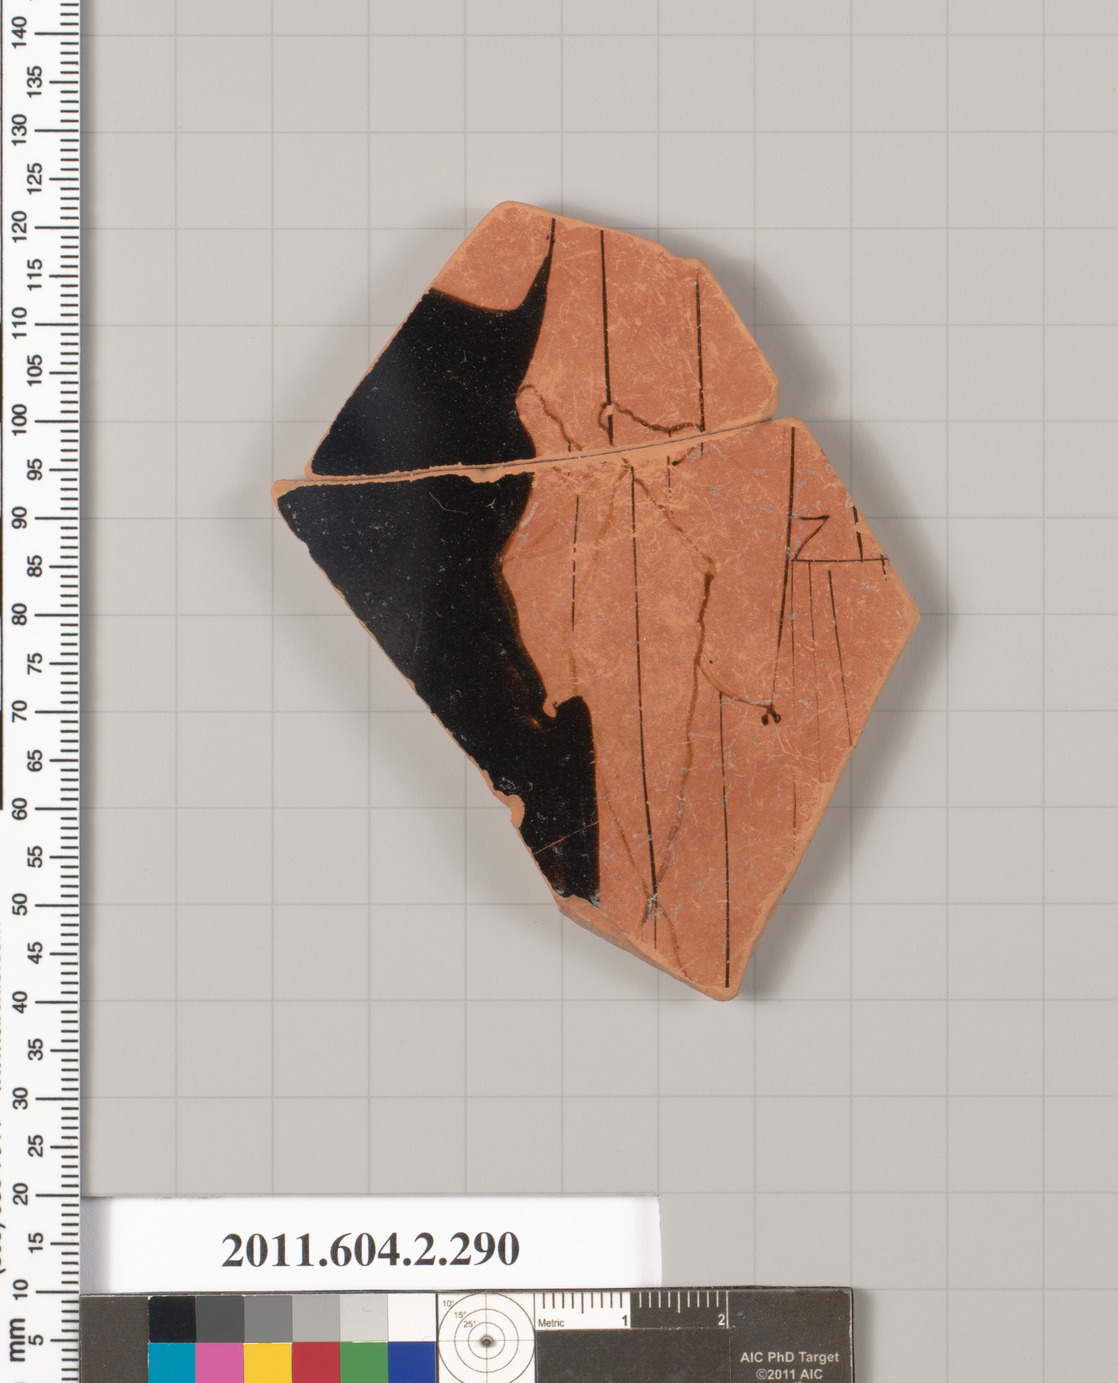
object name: column krater fragment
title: Terracotta fragment of a column-krater (bowl for mixing wine and water)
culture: greek, attic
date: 460-440 BCE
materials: terracotta